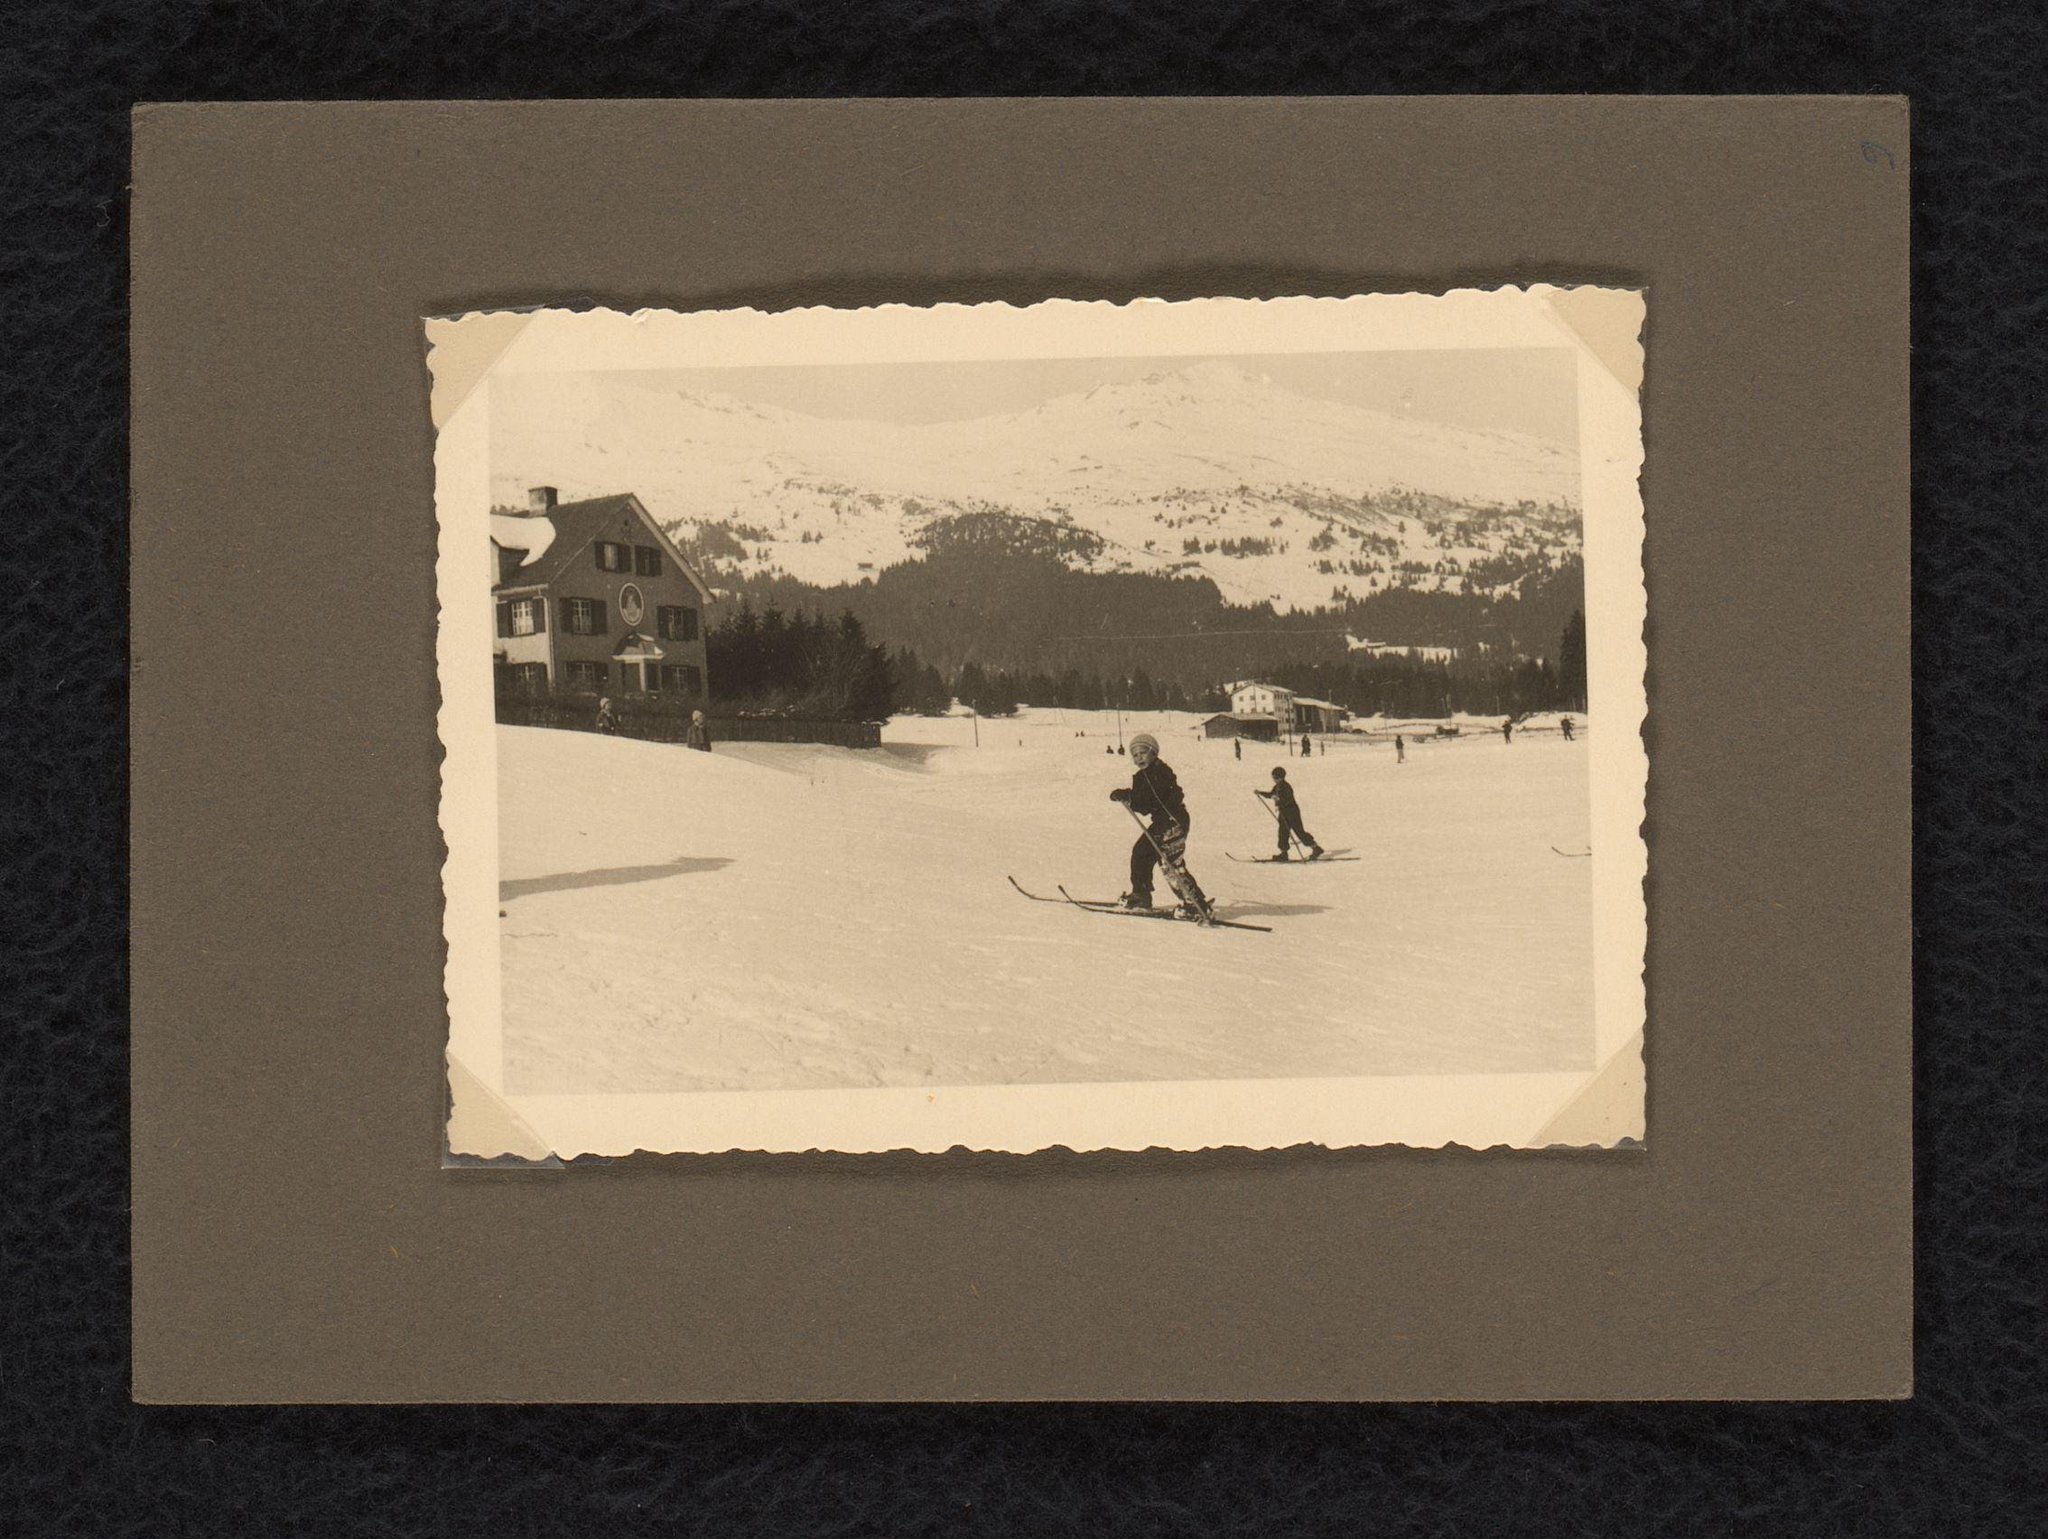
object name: photograph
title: Isabel op de ski's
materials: cardboard, photographic support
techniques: gelatin silver print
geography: lenzerheide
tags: isabel wachenheimer-elon, skis (winter sports), the family travelling, on holiday, snow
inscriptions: date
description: Albumblad met een foto van Isabel Wachenheimer op ski's in de sneeuw. Onderdeel van het fotoalbum met vakantiefoto's Lenzerheide, 1934.